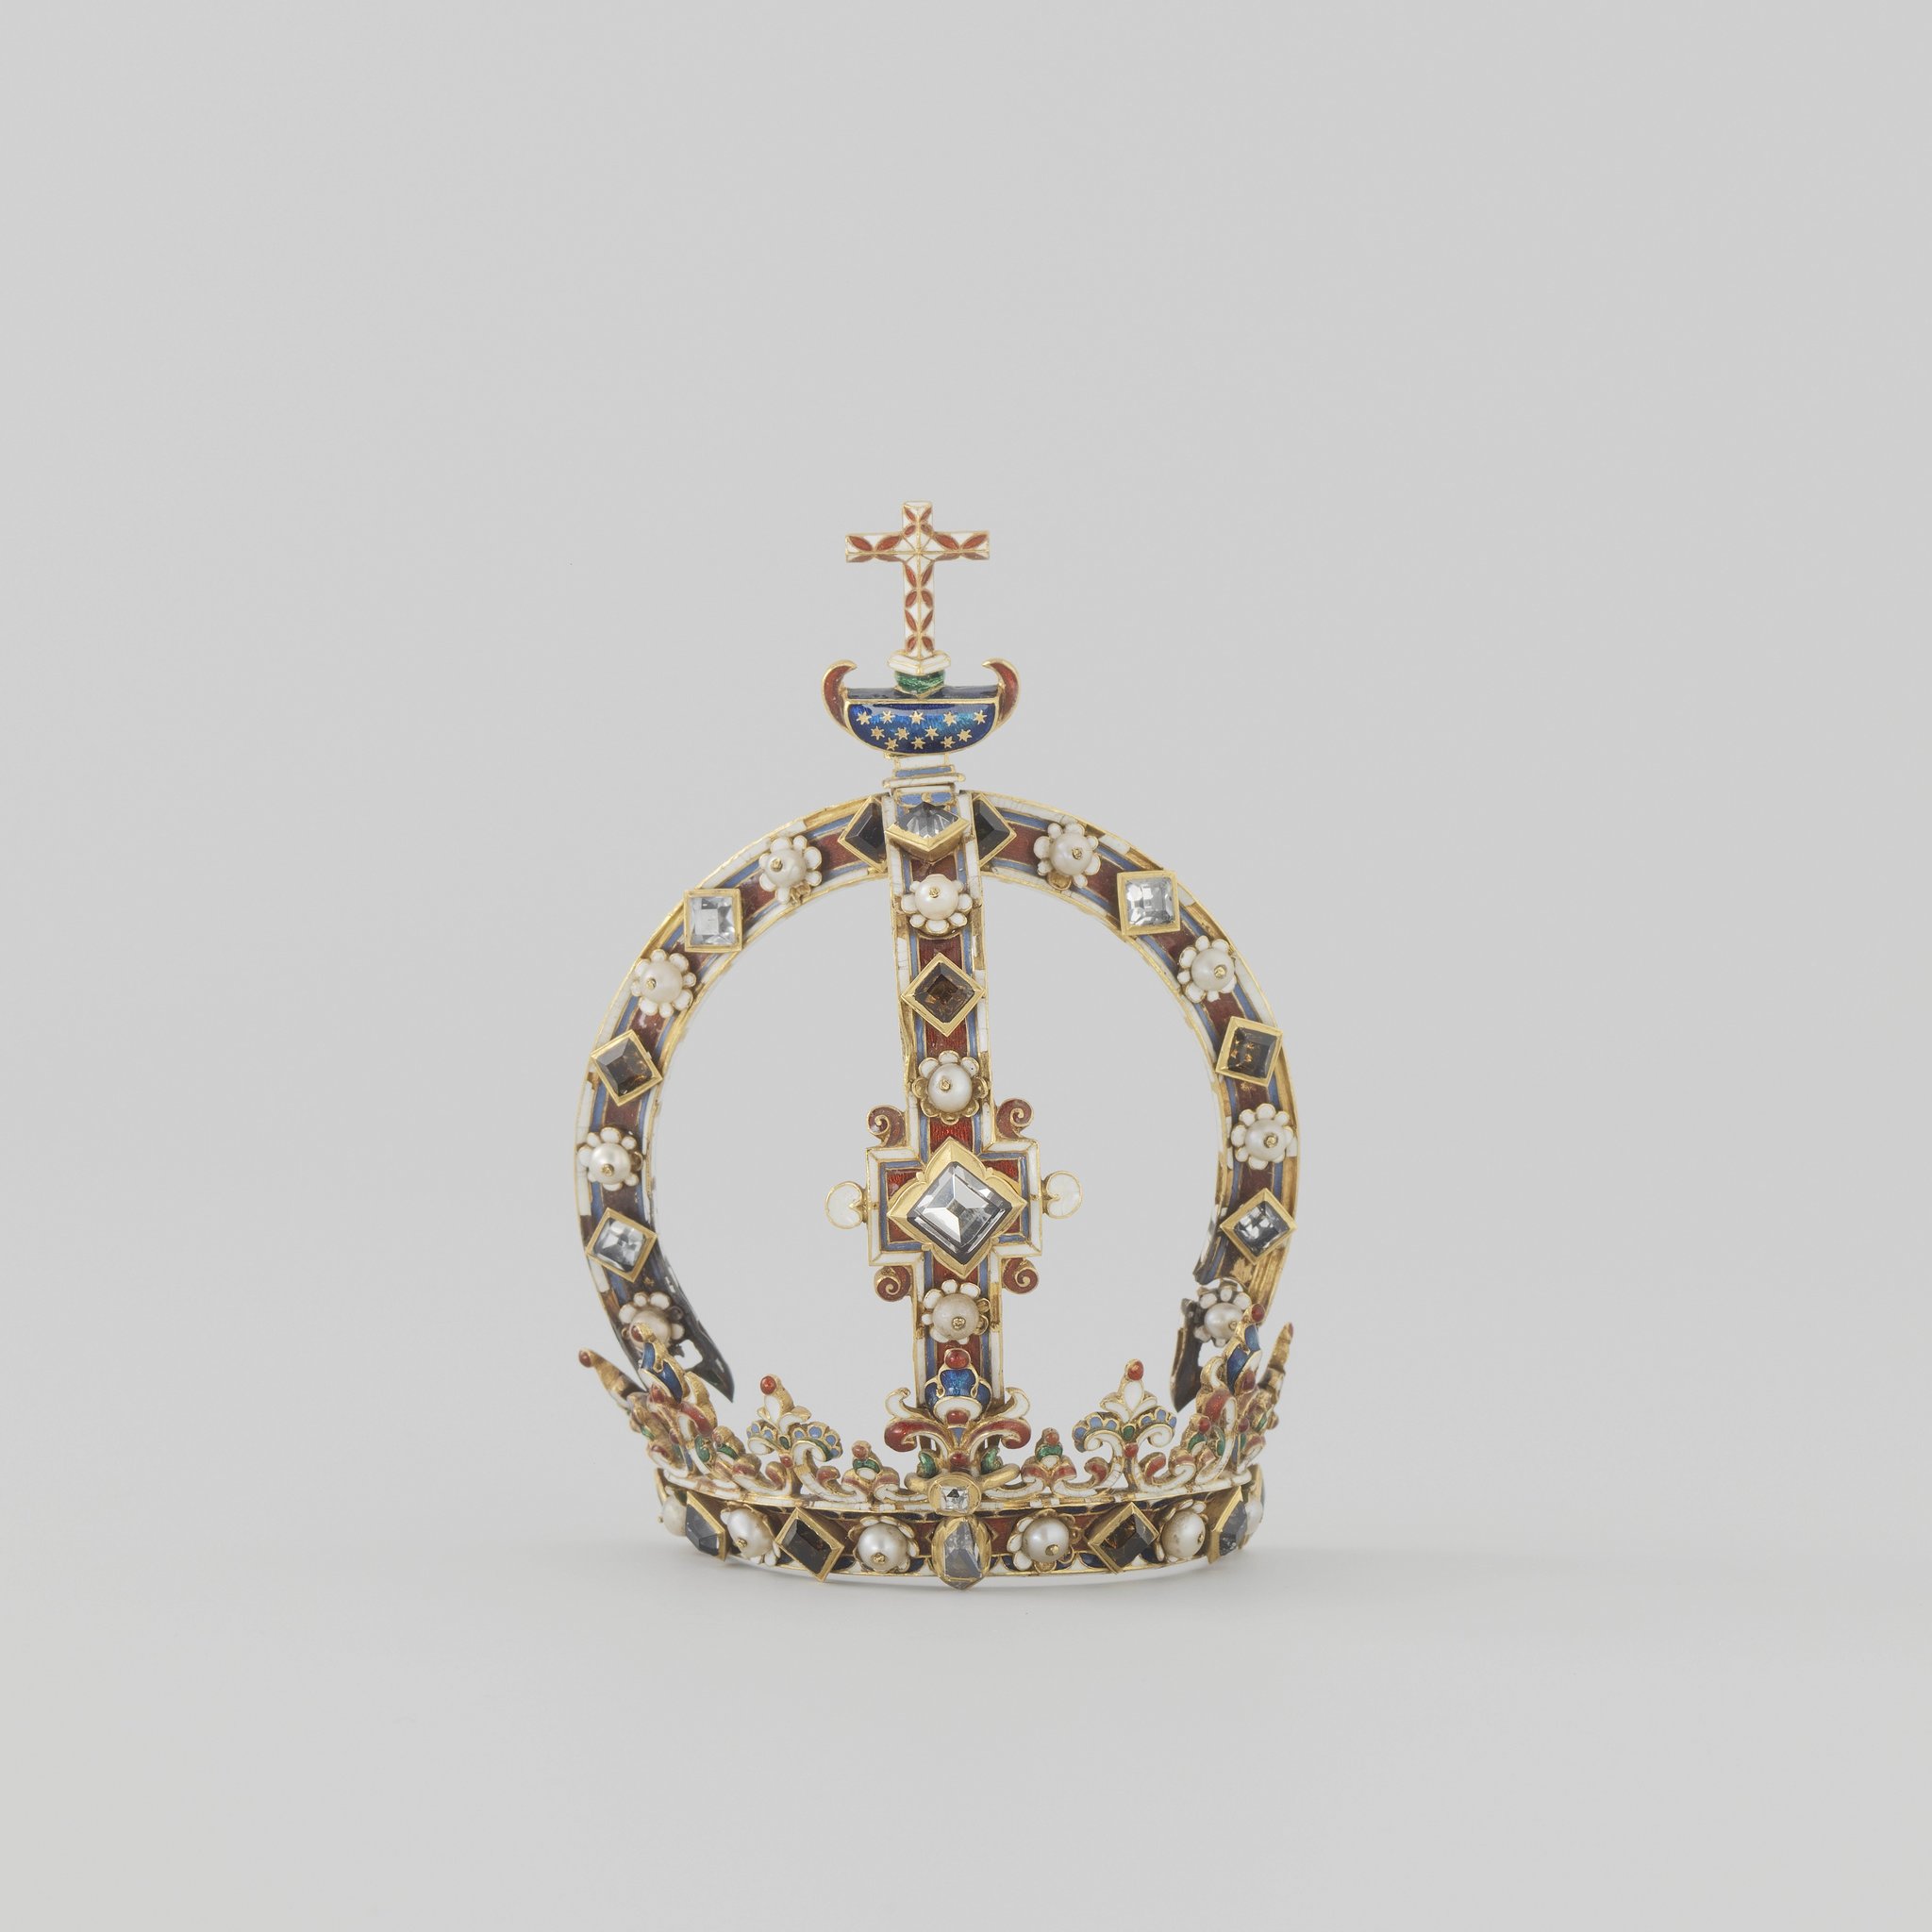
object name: crown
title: Christuskroon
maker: Anonymous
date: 1550-1600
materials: gold, pearl, gemstone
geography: spain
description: Two half crowns from a statue of the Virgin and Child. Gold, gems, pearls and enamel. Spain, c. 1550-1600.